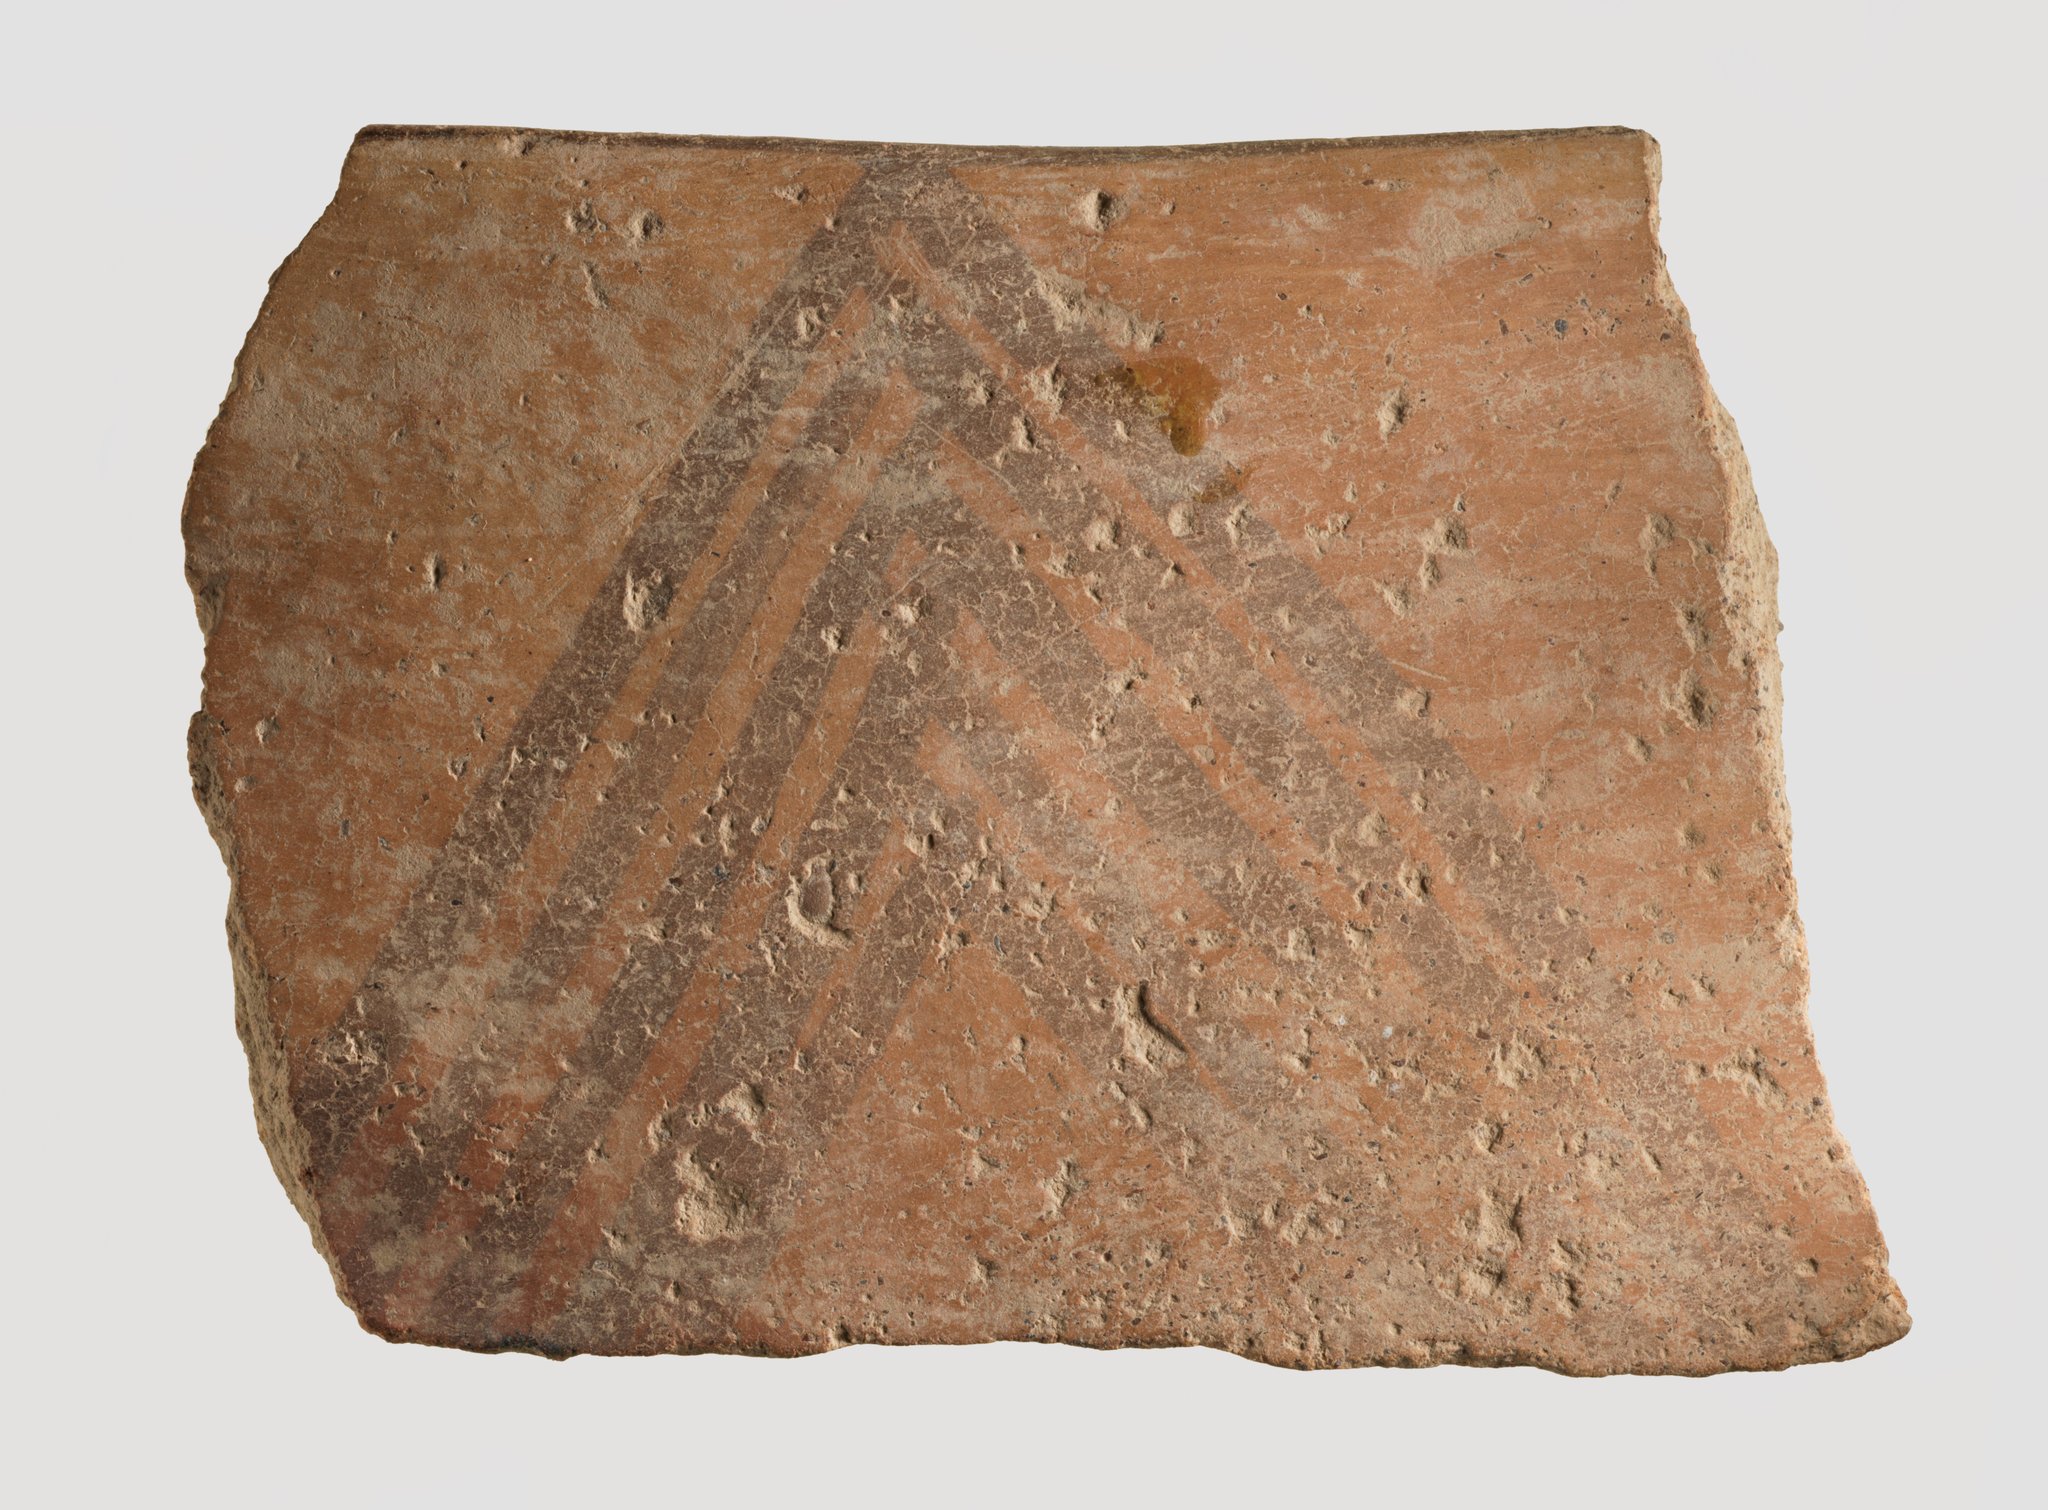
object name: sherd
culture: iranian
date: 3500-3100 BCE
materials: ceramic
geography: iran